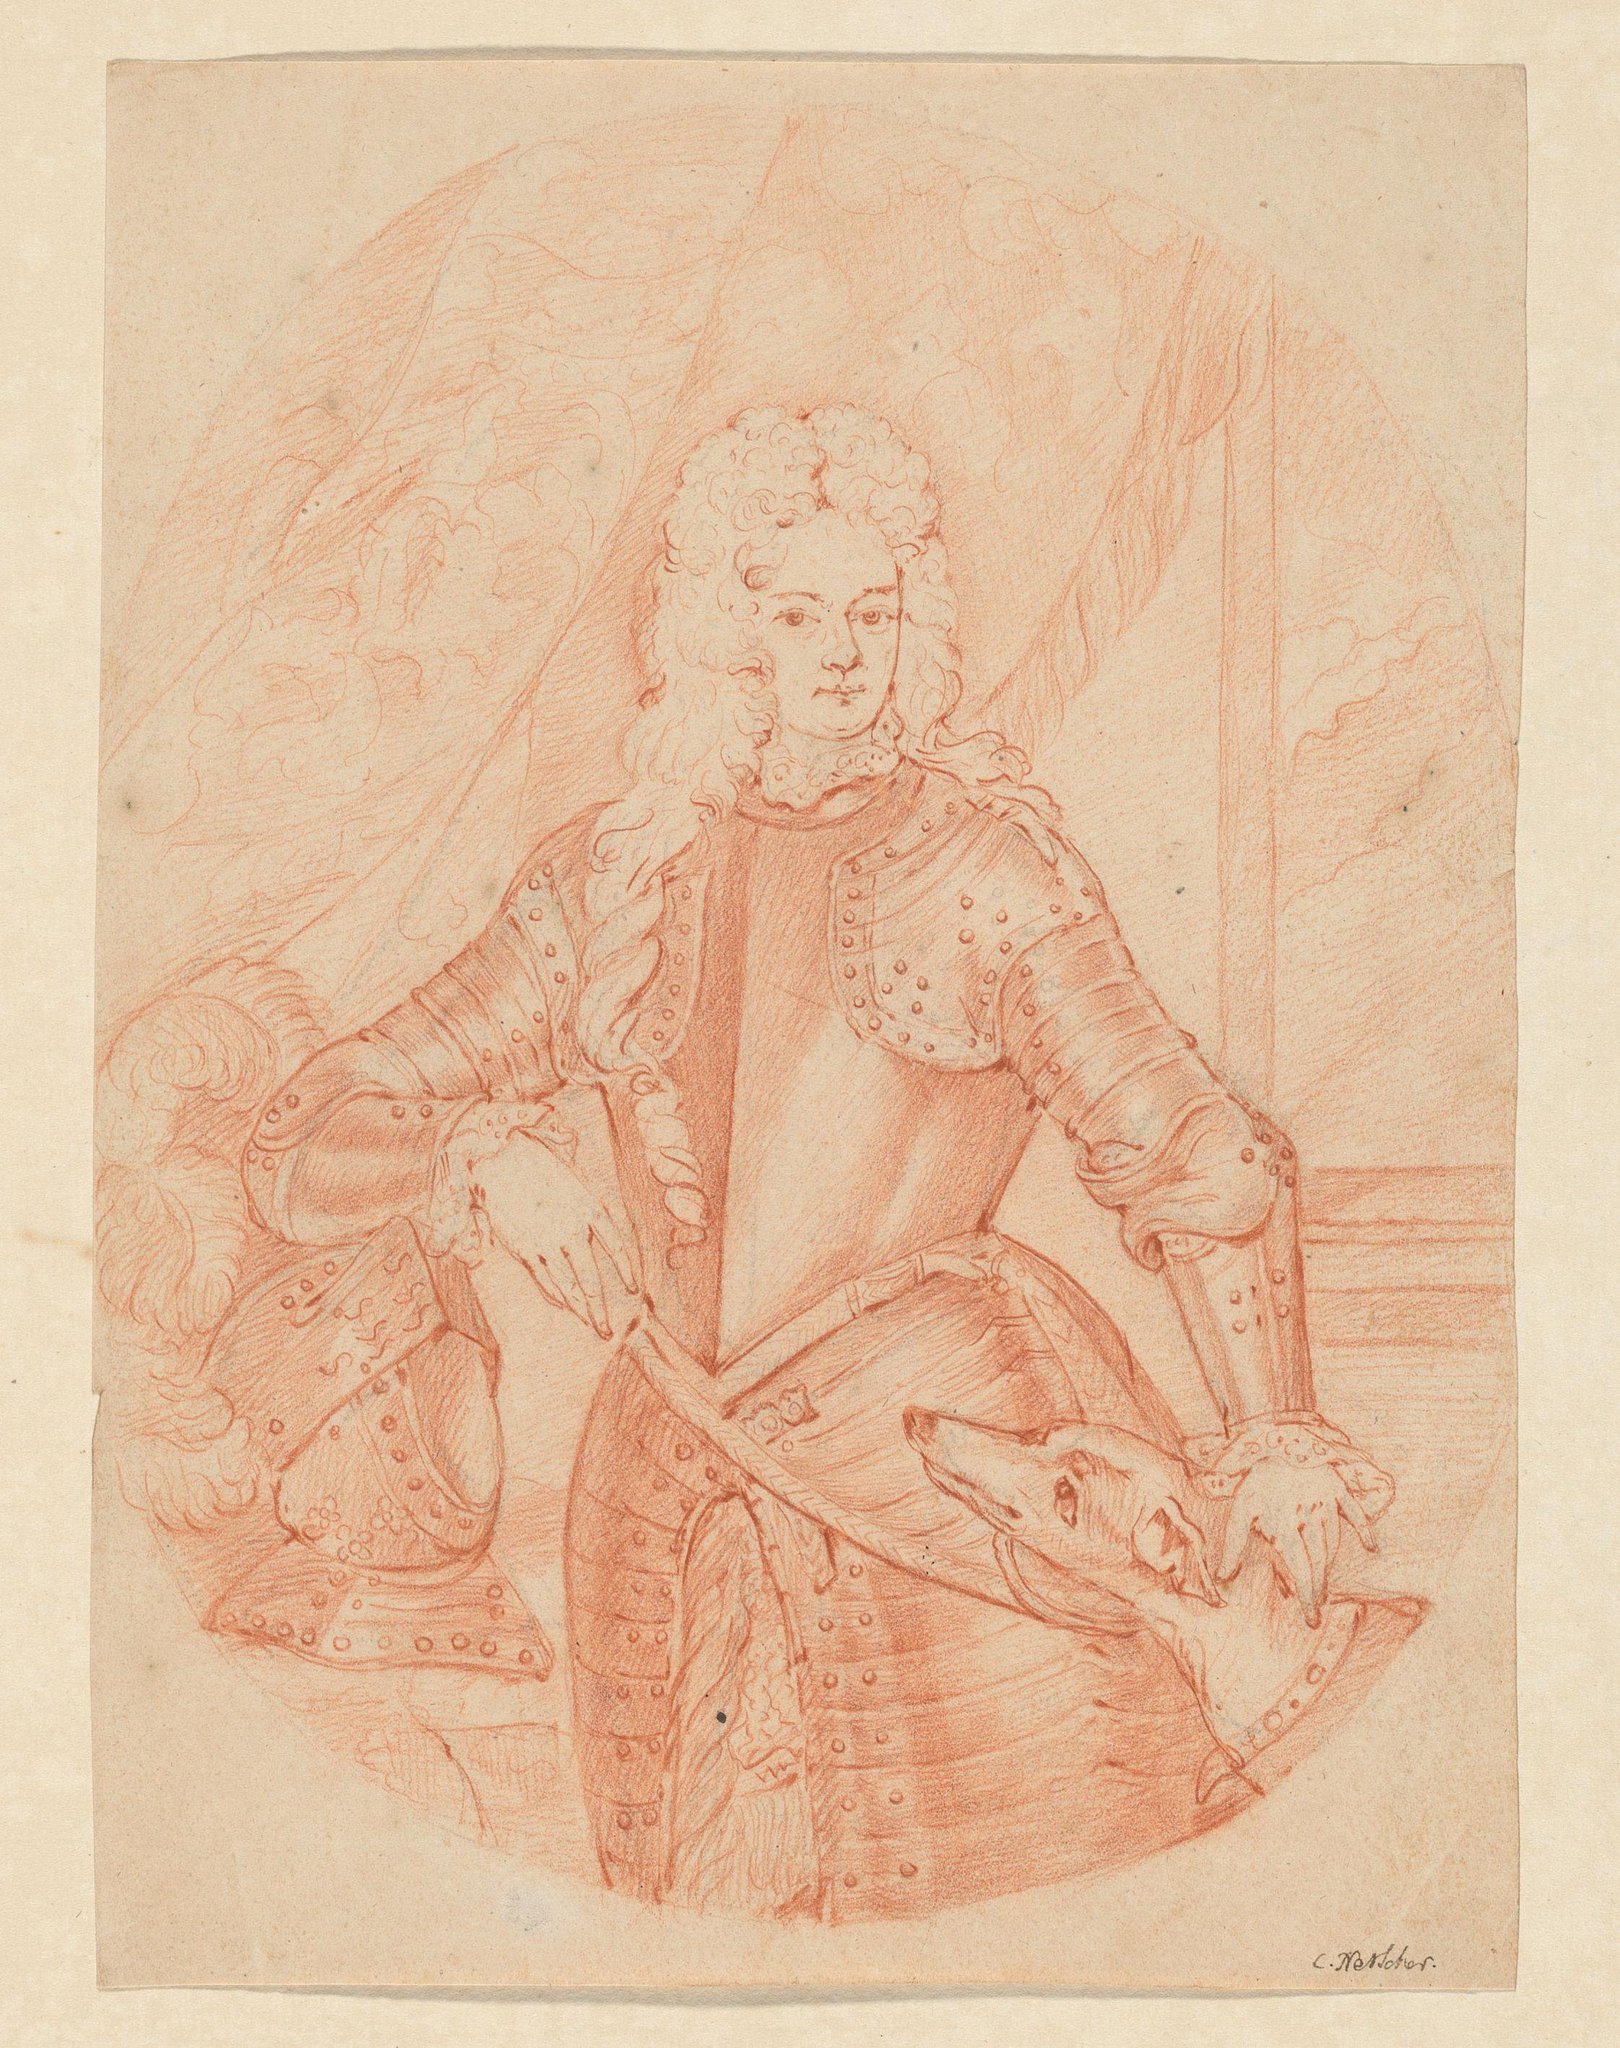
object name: album leaf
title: Portret van een geharnaste man met hond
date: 1649-1723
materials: chalk, paper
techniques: pasting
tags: helmet, armour, dog, historical persons not known by name